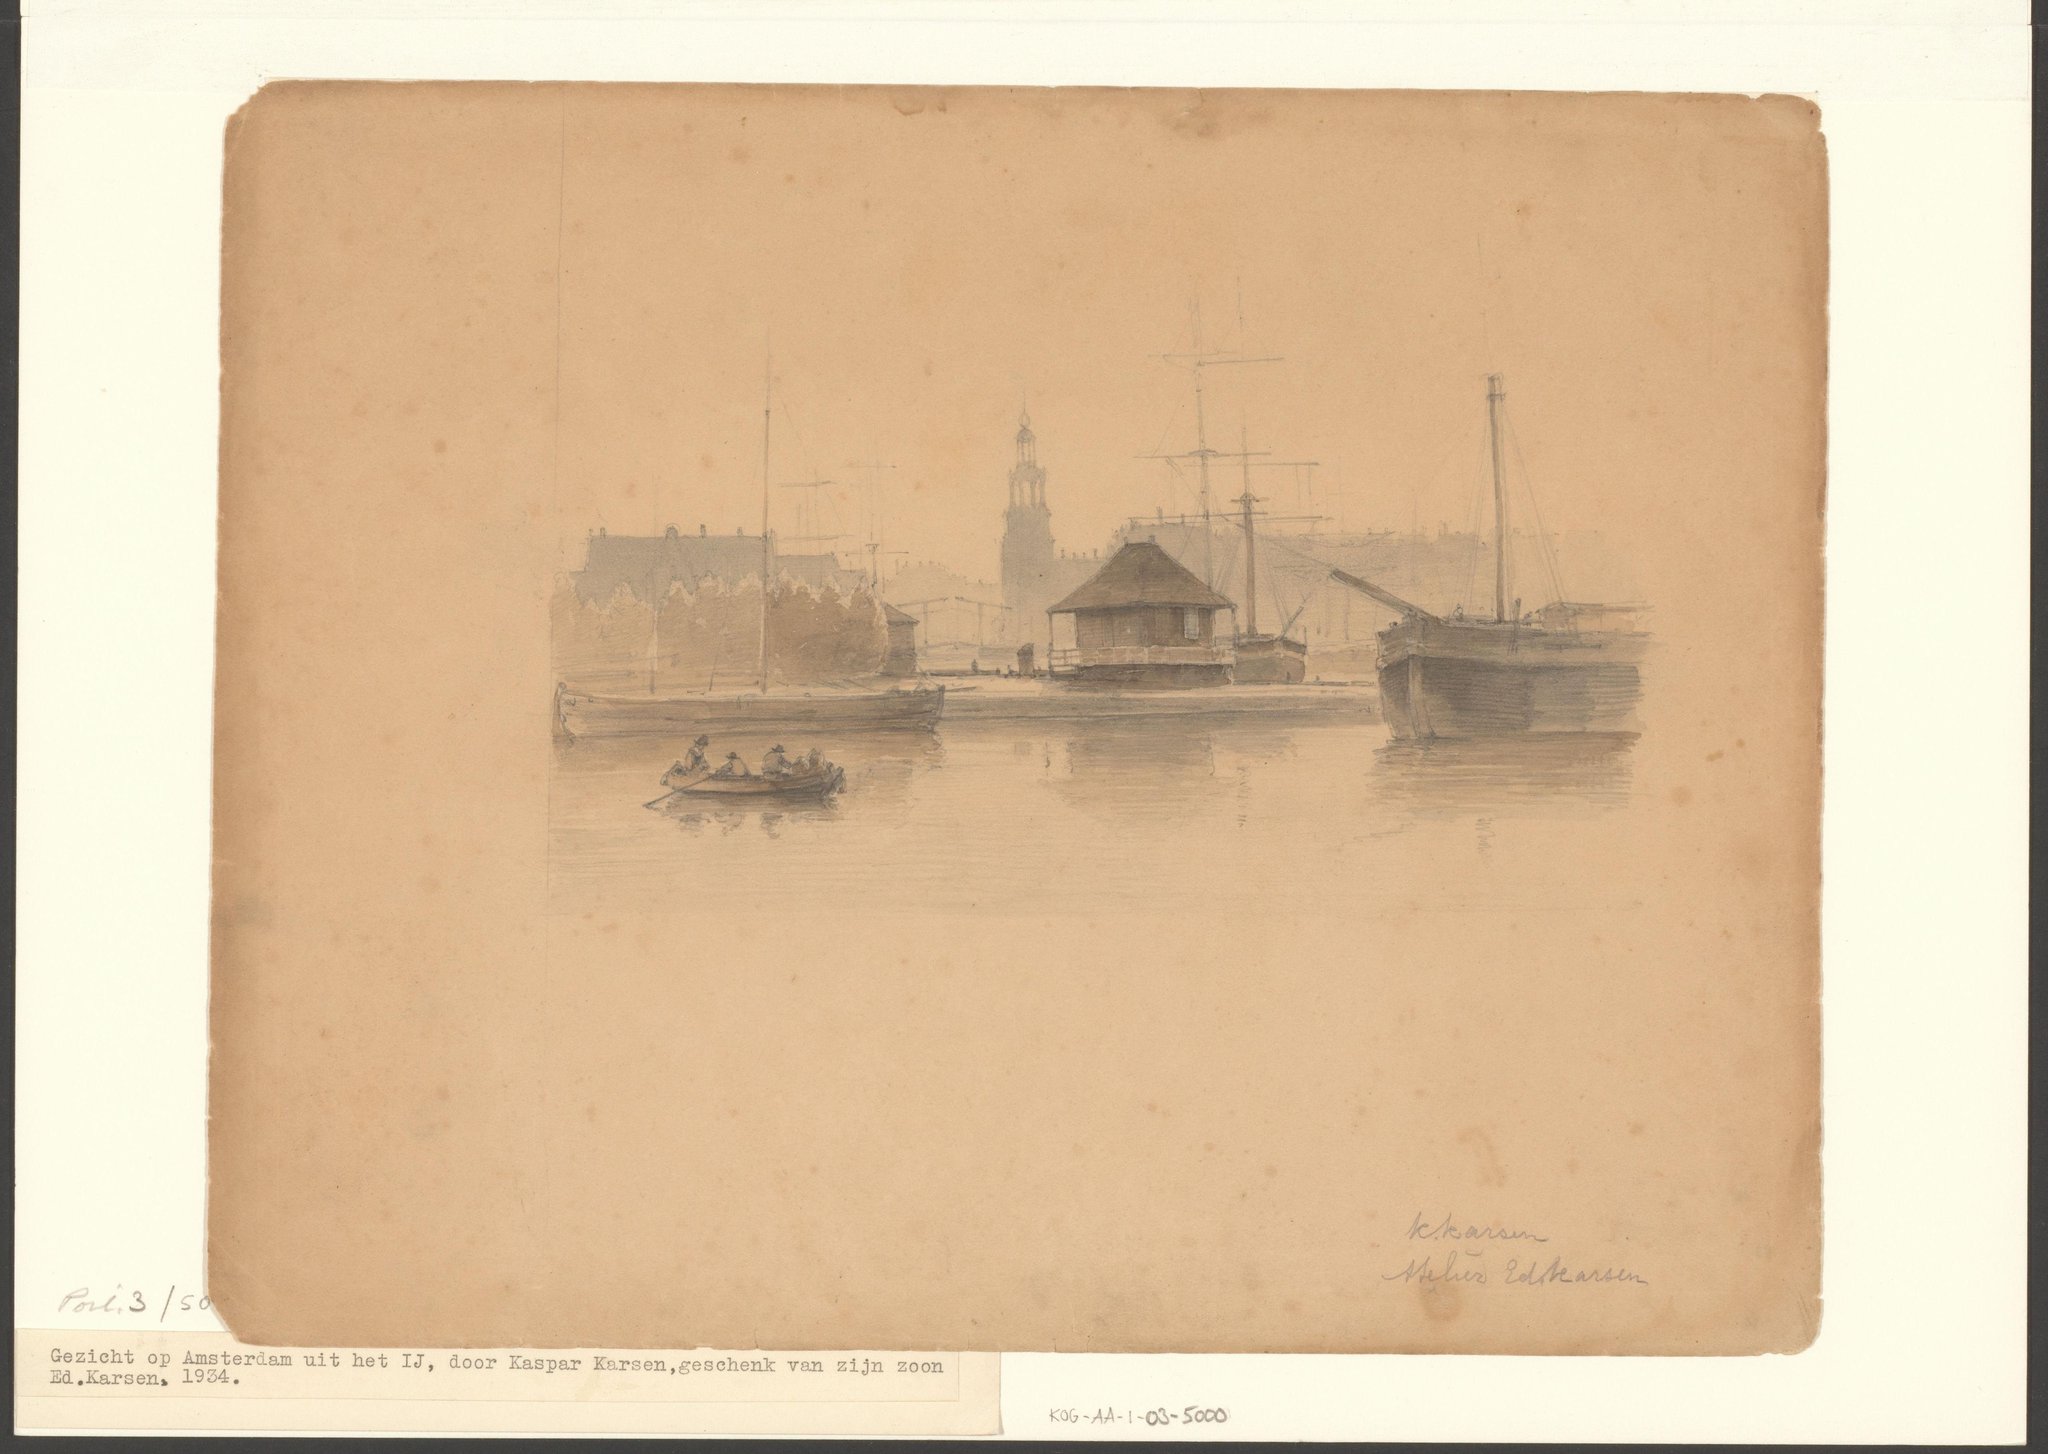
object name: drawing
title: Gezicht op de haven van Amsterdam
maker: kasparus karsen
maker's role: draughtsman, painter, print maker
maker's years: 1810-1896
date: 1820-1896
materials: ink, paper, pencil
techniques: brush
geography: amsterdam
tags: harbour, tower, clock tower ~ monumental adornment, city-view in general; 'veduta', river, port of amsterdam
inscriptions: signature: ‘k.karsen / Atelier Ed.Karsen’, inscription: ‘Port. 3 / 5000’, inscription: ‘Gezicht op Amsterdam (...) Ed. Karsen, 1934.’, collector's mark: ‘3’ Lugt 1641b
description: Onderwerpsrubriek binnen de Atlas Amsterdam: Gezichten van het IJ op het westelijk gedeelte der stad, Blauwhoofd tot Nieuwebrug.